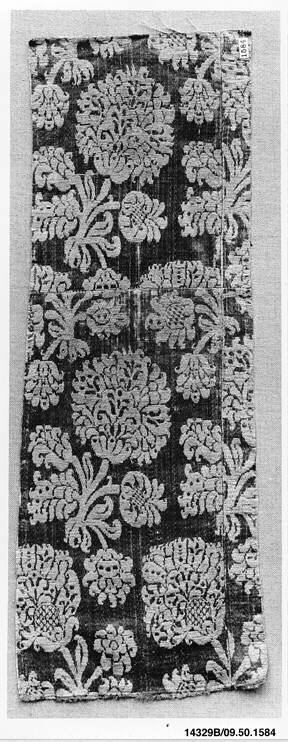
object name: fragment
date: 1701-1800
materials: cotton, silk